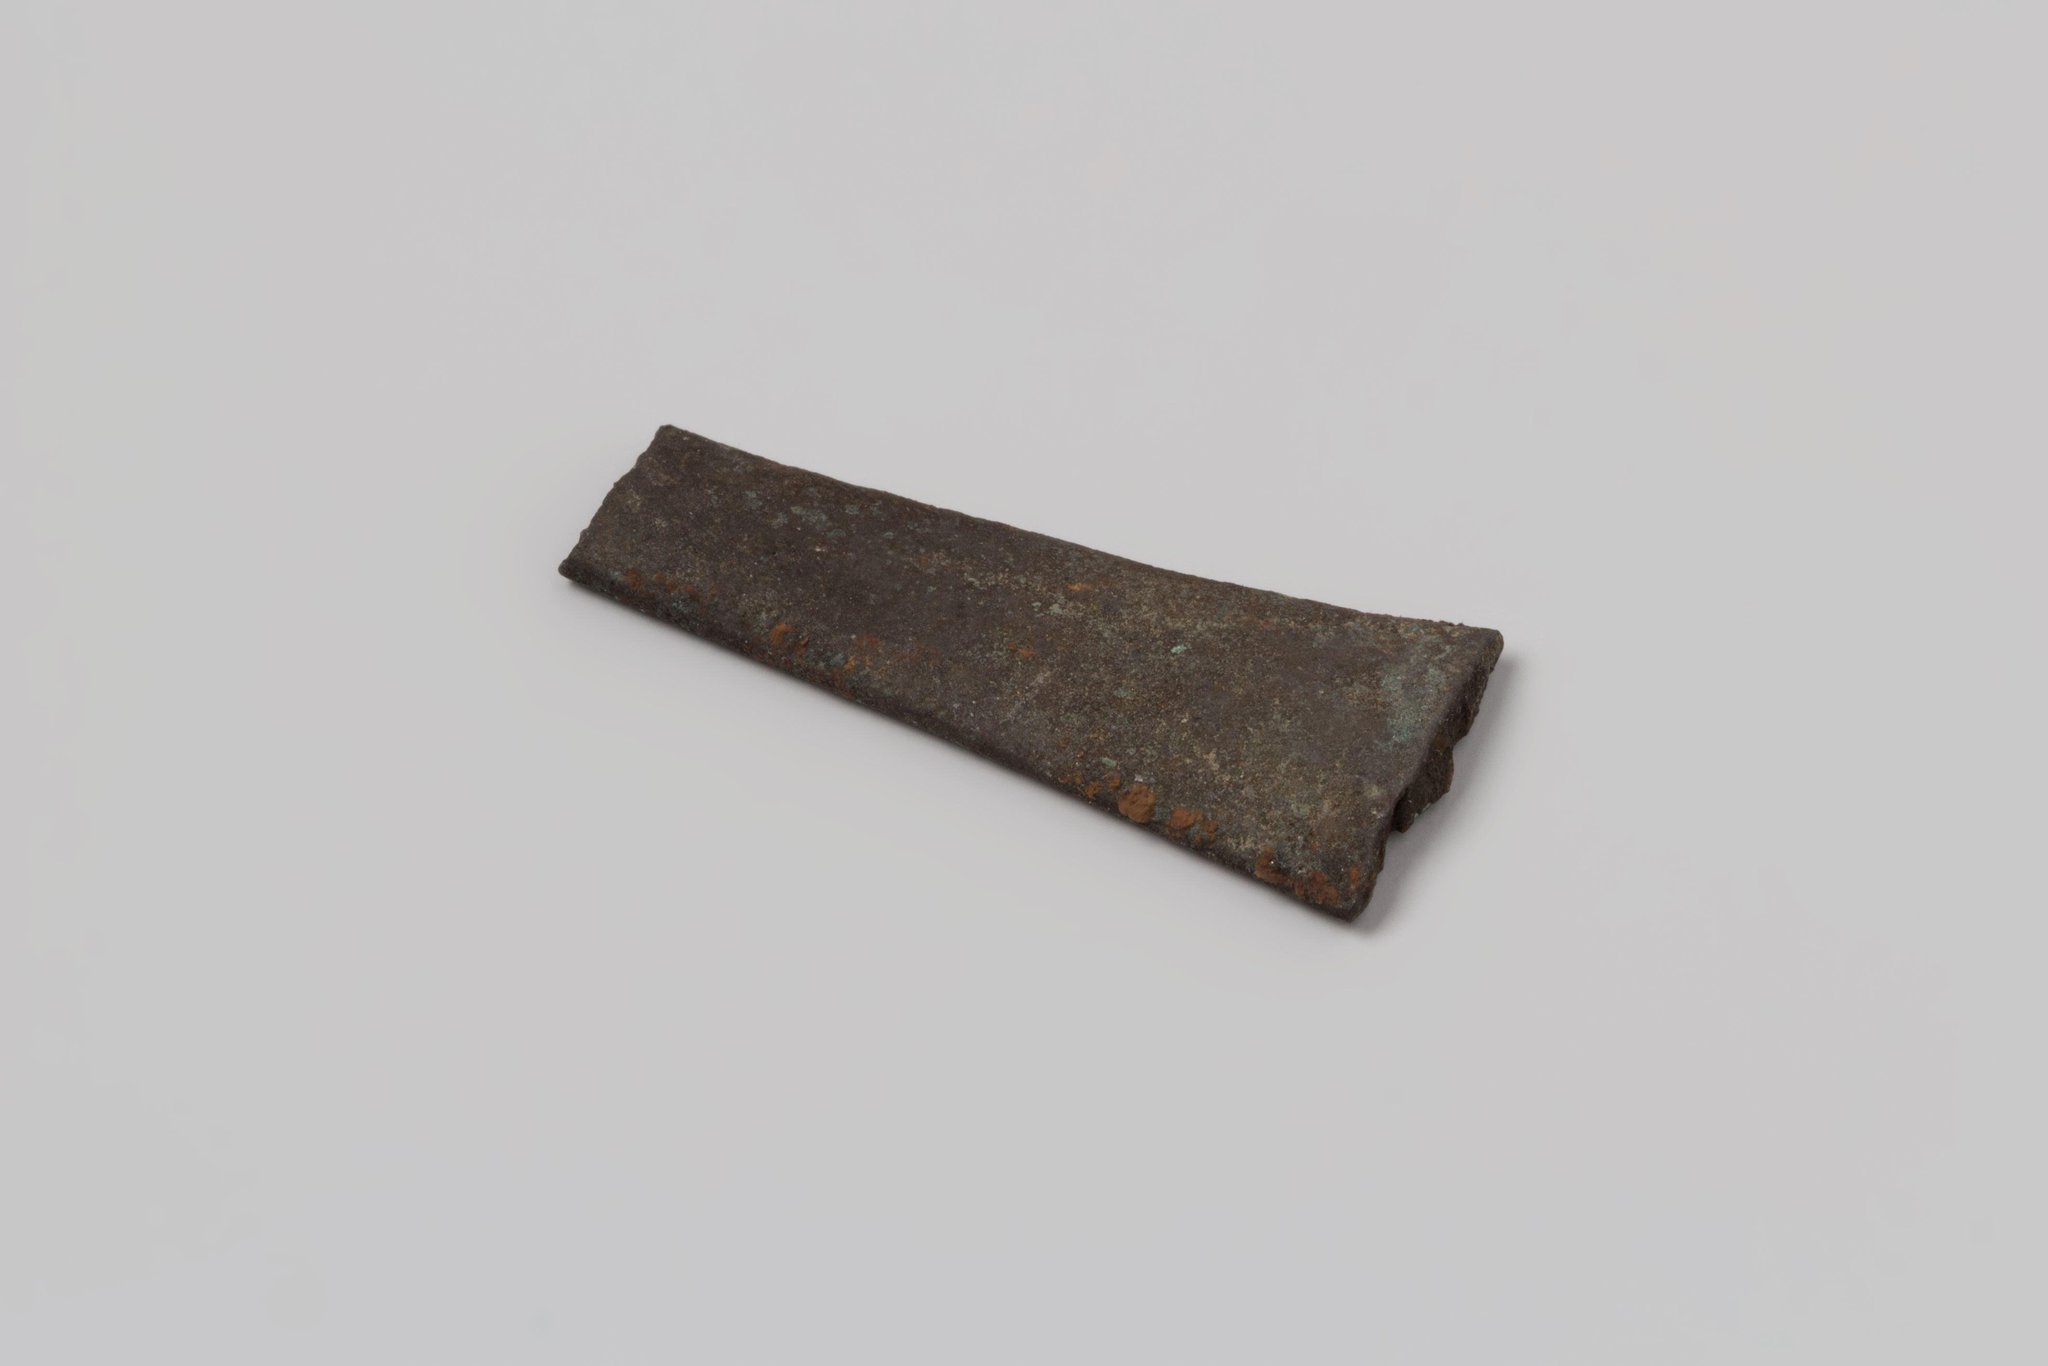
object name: spoon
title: Fragment steel van vork of lepel uit het wrak van de Oost-Indiëvaarder Hollandia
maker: Anonymous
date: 1700-1743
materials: copper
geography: netherlands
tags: verenigde oostindische compagnie, hollandia (schip), annet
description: Cutlery, fragment: stem of fork or spoon; fragm, sim. NG 1980-27H536a.